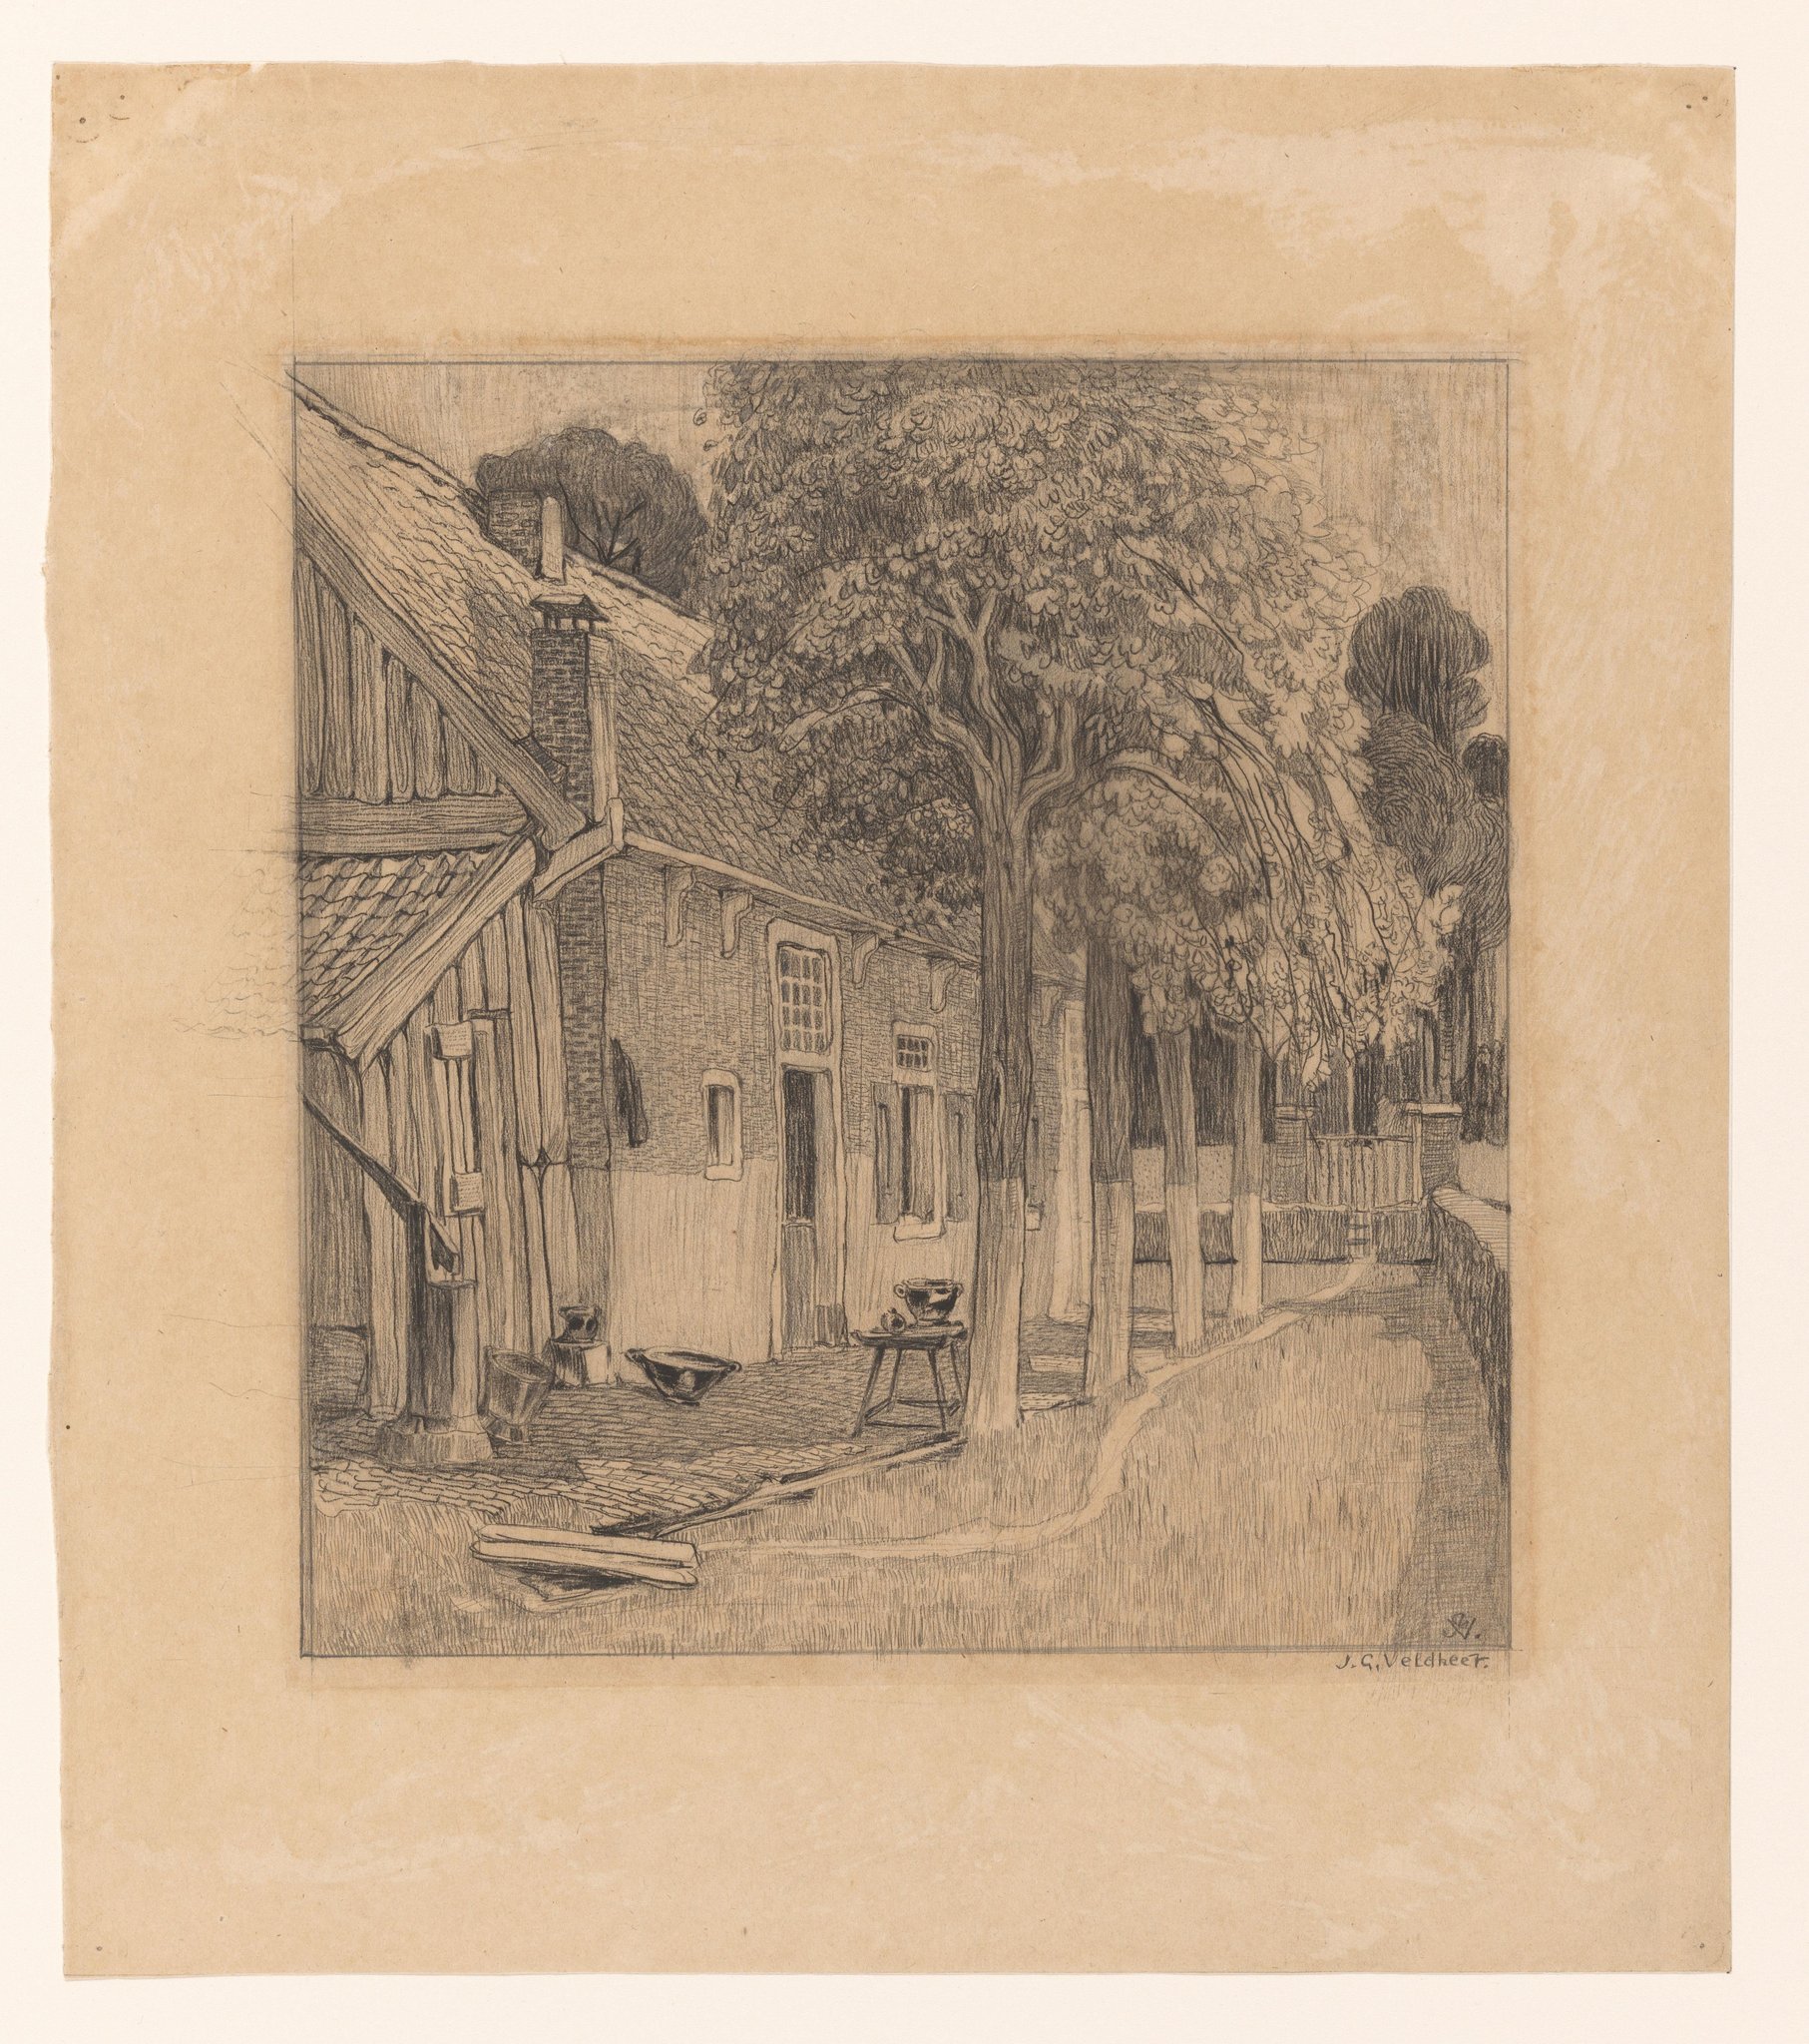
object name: drawing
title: Dorpshuis, waarschijnlijk te Laren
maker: jacobus gerardus veldheer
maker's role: draughtsman, print maker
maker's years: 1866-1954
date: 1876-1954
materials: chalk, paper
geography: laren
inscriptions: monogram, signature: ‘J.G.Veldheer’